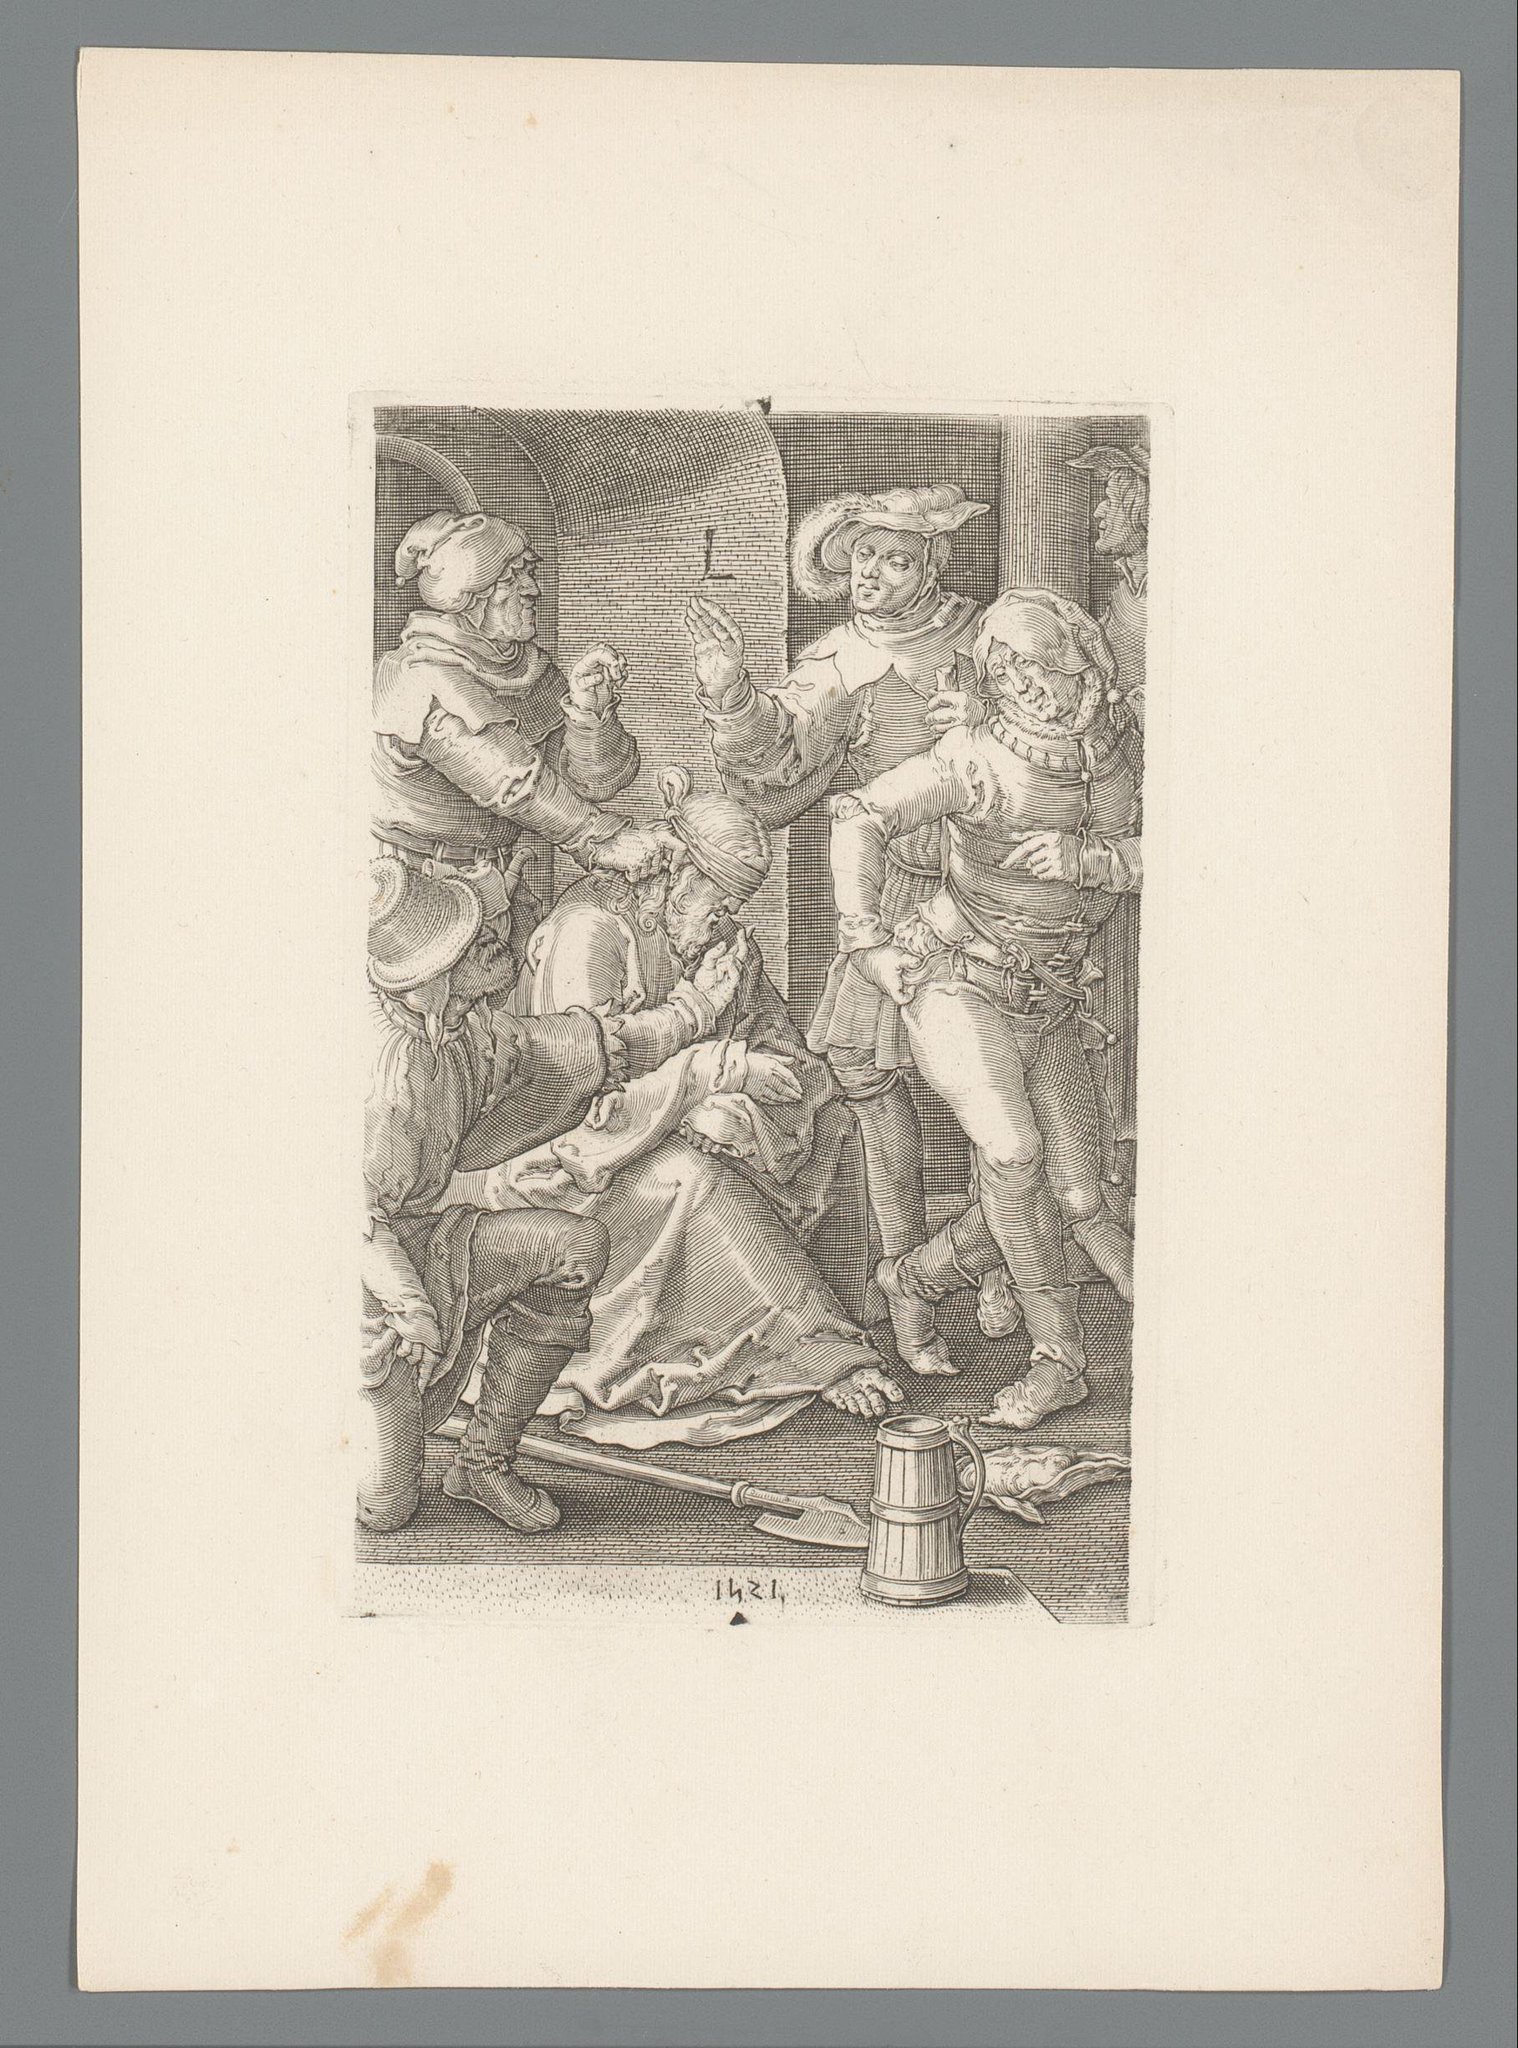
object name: print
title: Die Leiden Christi 14 Blatt. Nach Lucas von Leyden in Kupfer gestochen von J. Müller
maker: jan harmensz. muller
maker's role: draughtsman, print maker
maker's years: 1571-1628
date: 1800-1891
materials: paper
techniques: engraving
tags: mockings of christ, who may be blindfolded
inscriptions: collector's mark: Lugt 2227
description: Maakt deel uit van een serie die in de negentiende eeuw is herdrukt met de titel: Die Leiden Christi 14 Blatt. Nach Lucas von Leyden in Kupfer gestochen von J. Müller.